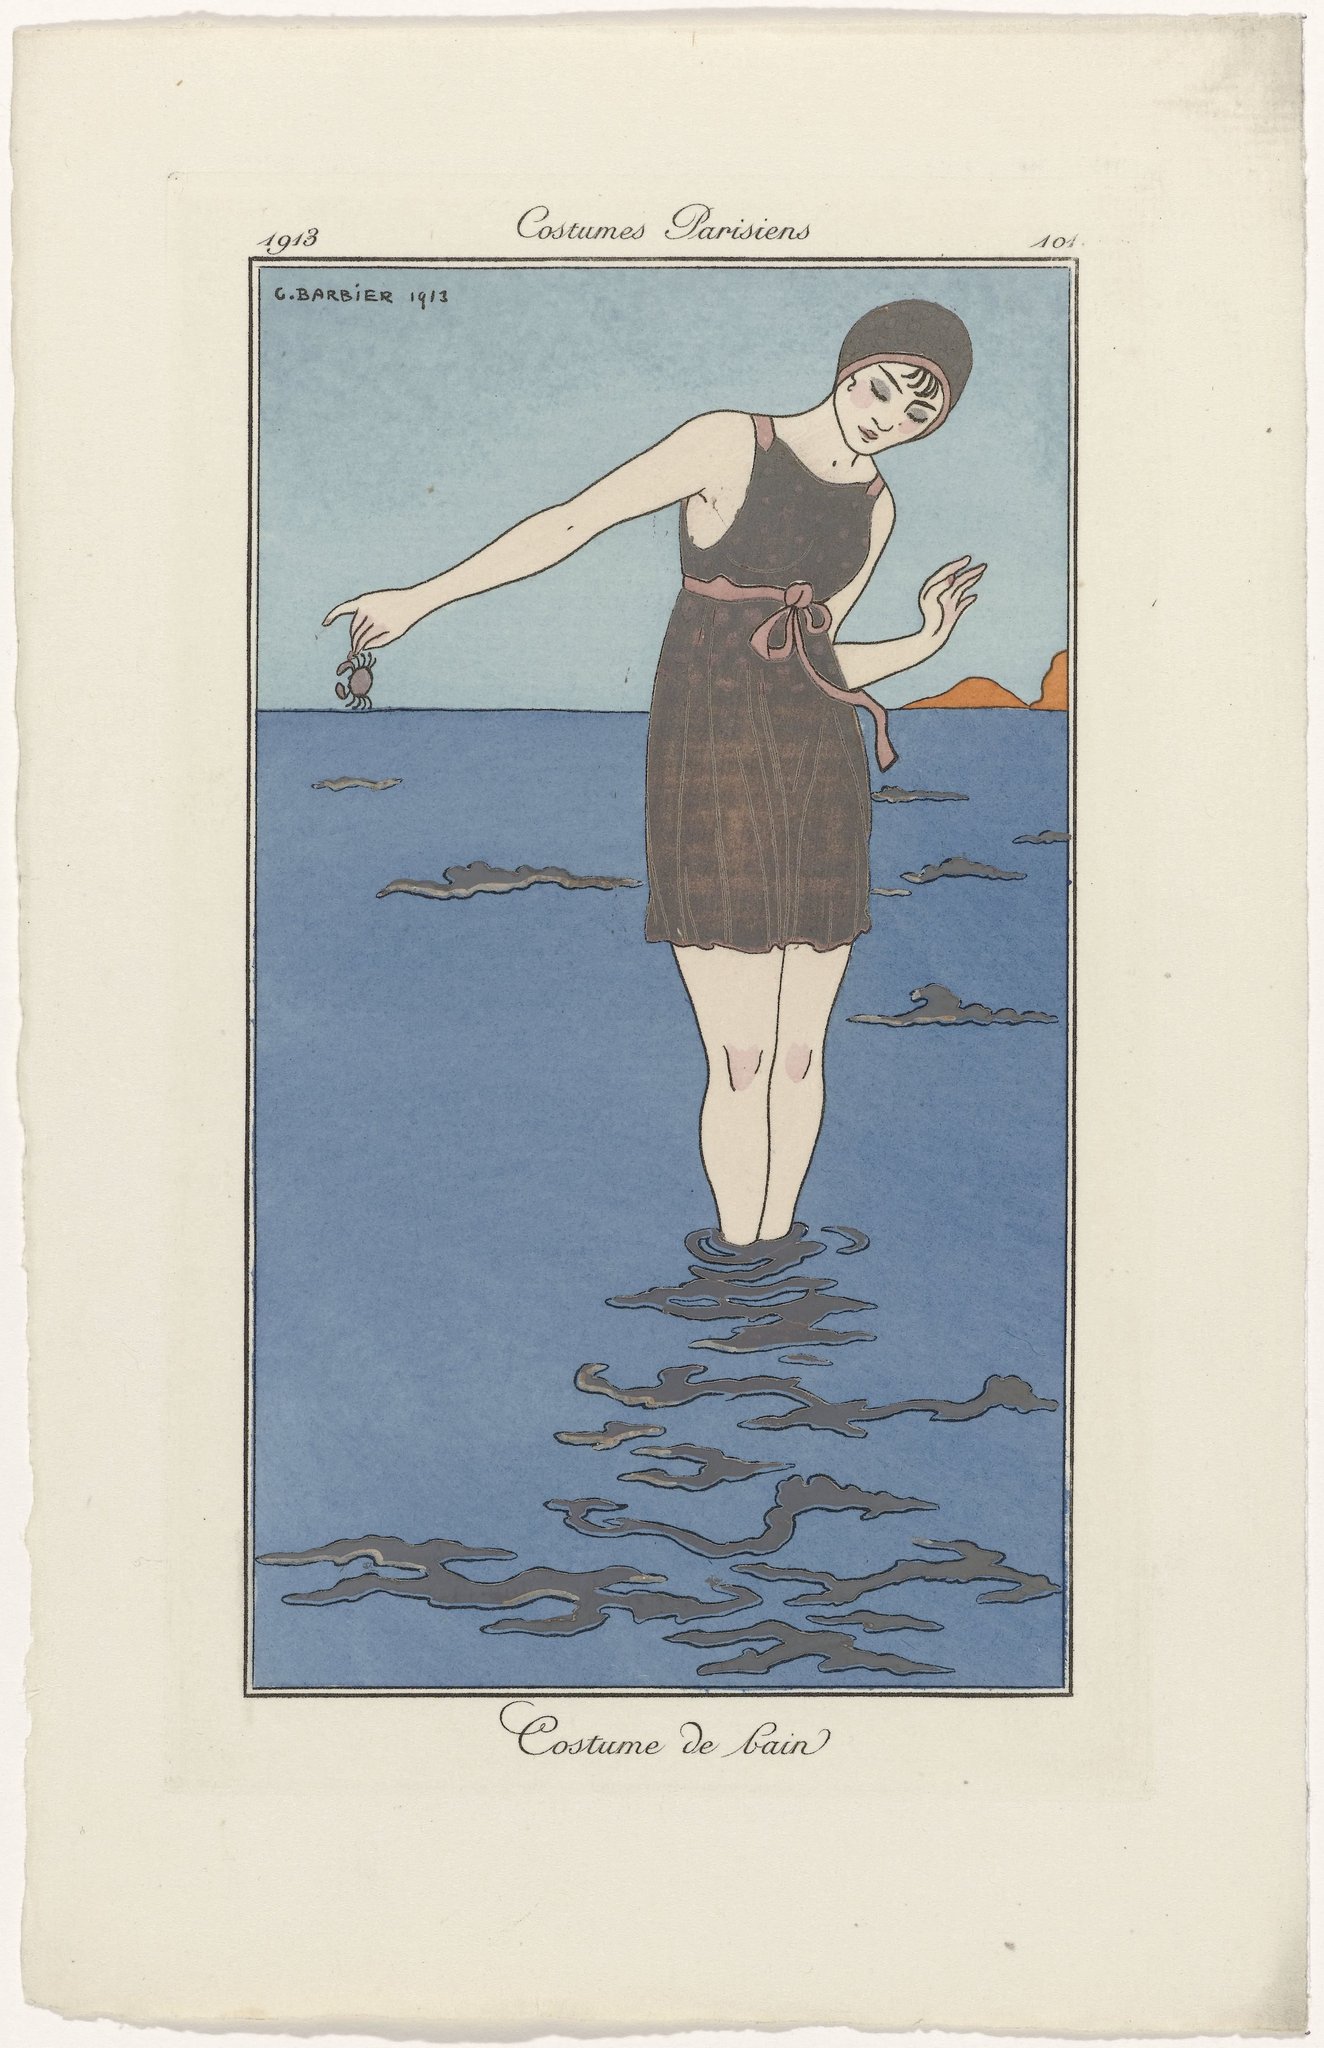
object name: fashion print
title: Journal des Dames et des Modes, Costumes Parisiens, 1913, No. 101 : Costume de bain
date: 1913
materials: paper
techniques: engraving, hand coloring, pochoir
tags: movement in water, crustaceans: crab (+ man and animal), head-gear: cap (+ women's clothes), fashion plates, dress, gown (+ women's clothes), in or beside the water (on the beach)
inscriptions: caption: ‘Costume de bain’, title: ‘Costumes Parisiens’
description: Vrouw, staand in het water, gekleed in zwemkleding of badkleding. Zij houdt een krab ver van zich af. Prent uit het modetijdschrift Journal des Dames et des Modes (1912-1914).